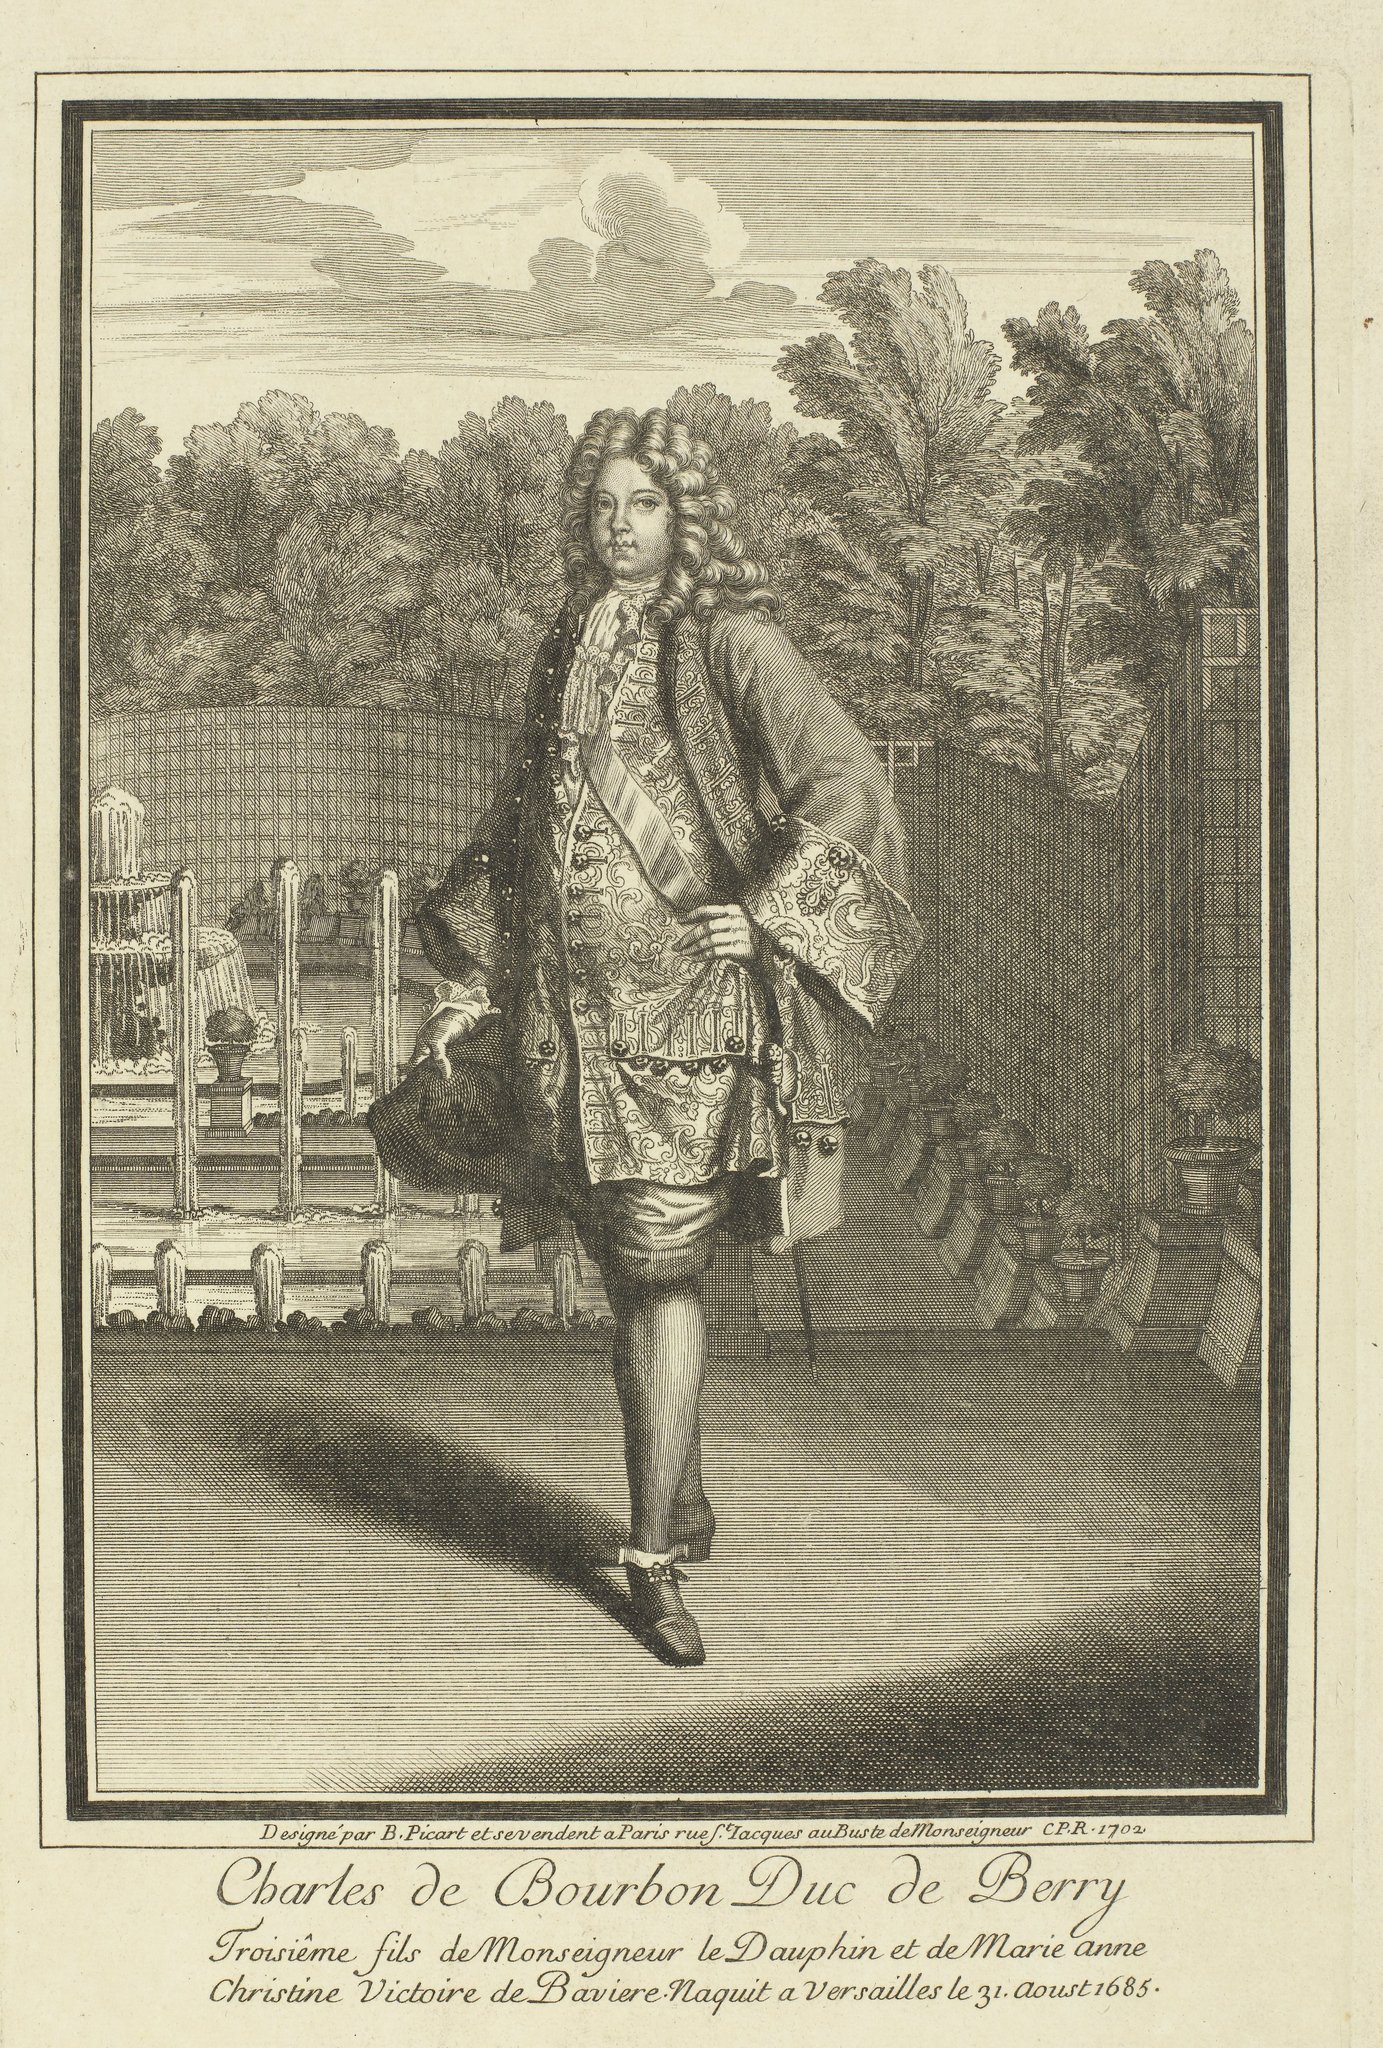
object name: print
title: Leden van de Franse koninklijke familie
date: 1702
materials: paper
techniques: engraving, etching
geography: paris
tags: head-gear: tricorn (+ men's clothes), styles of hairdress (allonge), coat (justaucorps) (+ men's clothes), clothing for the upper part of the body (waistcoat) (+ men's clothes), head-gear: hat (+ men's clothes), shoes, sandals (+ men's clothes), clothes, costume (+ men's clothes), trousers, breeches, etc. (breeches) (+ men's clothes), stockings, socks (+ men's clothes)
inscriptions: collector's mark: Lugt 2228, address: ‘et se vendent a Paris rue St. jacques au Buste de Monseigneur C.P.R. 1702’, title: ‘Charles de Bourbon Duc de Berry / Troisieme fils de Monseigneur le Dauphin et de Marie Anne / Christine Victoire de Baviere, Naquit a versailles le 31. Aoust 1685’, date: ‘1702’, signature: ‘Dessigné par B. Picart’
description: Portret van Karel van Bourbon, prins van Frankrijk. Op de achtergrond een paleistuin met fonteinen. In de marge een drieregelig onderschrift in het Frans.